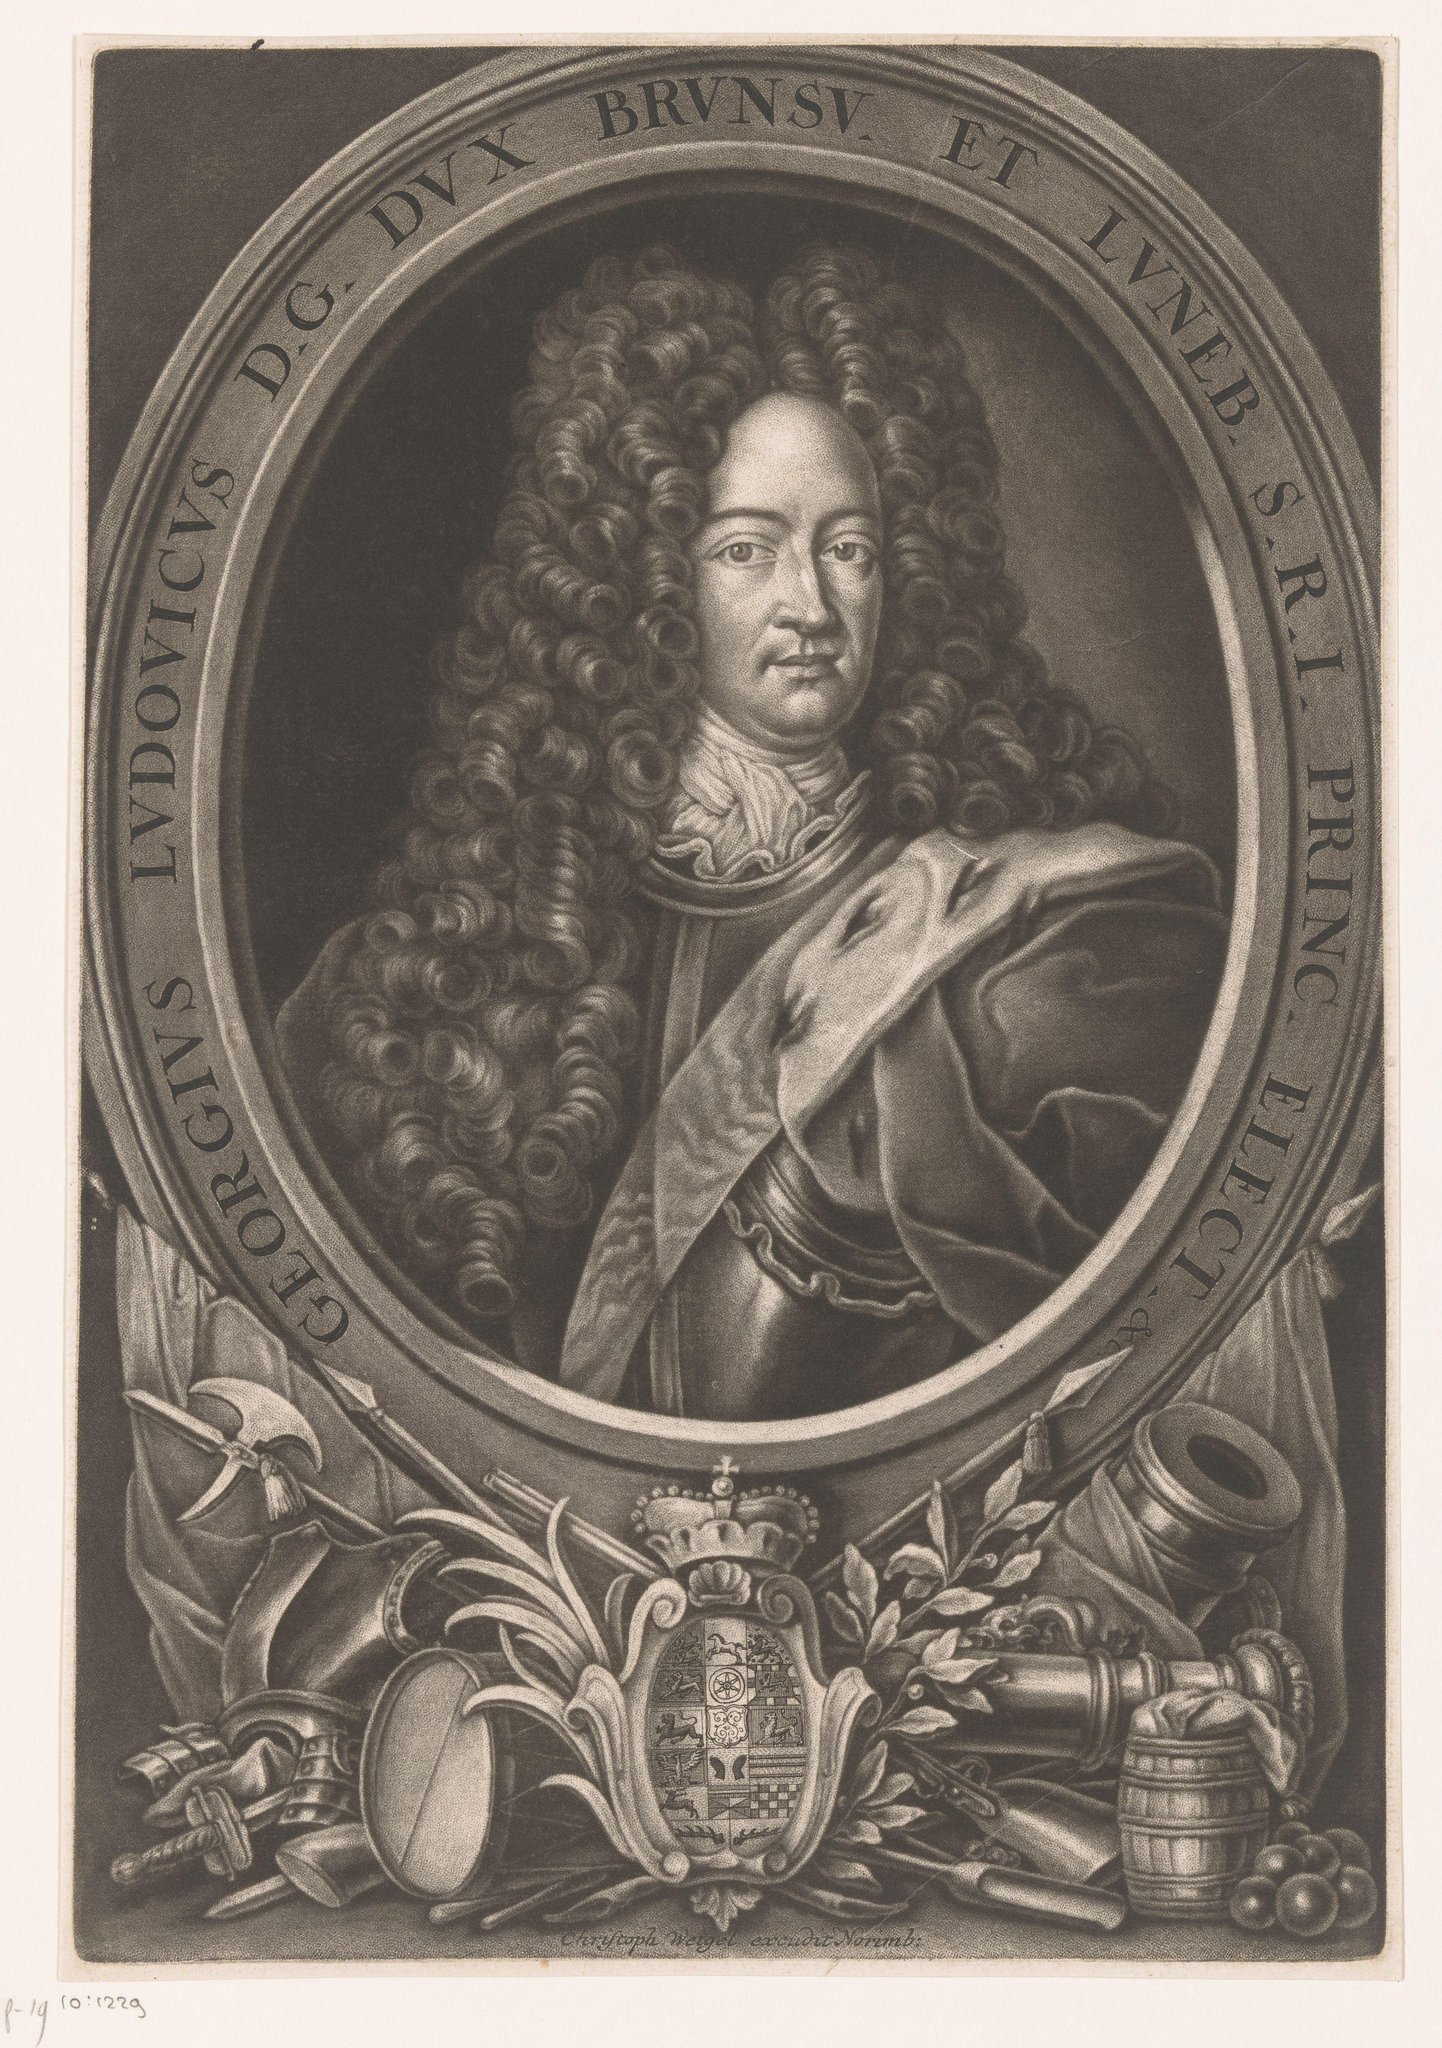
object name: print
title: Portret van George I, koning van Groot-Brittannië en Ierland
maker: christoph weigel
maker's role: goldsmith, print maker, publisher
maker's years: 1654-1725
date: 1670-1725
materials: paper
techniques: mezzotint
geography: nuremberg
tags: george i (koning van groot-brittannië en ierland), historical persons, armorial bearing, heraldry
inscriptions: collector's mark: Lugt 2228